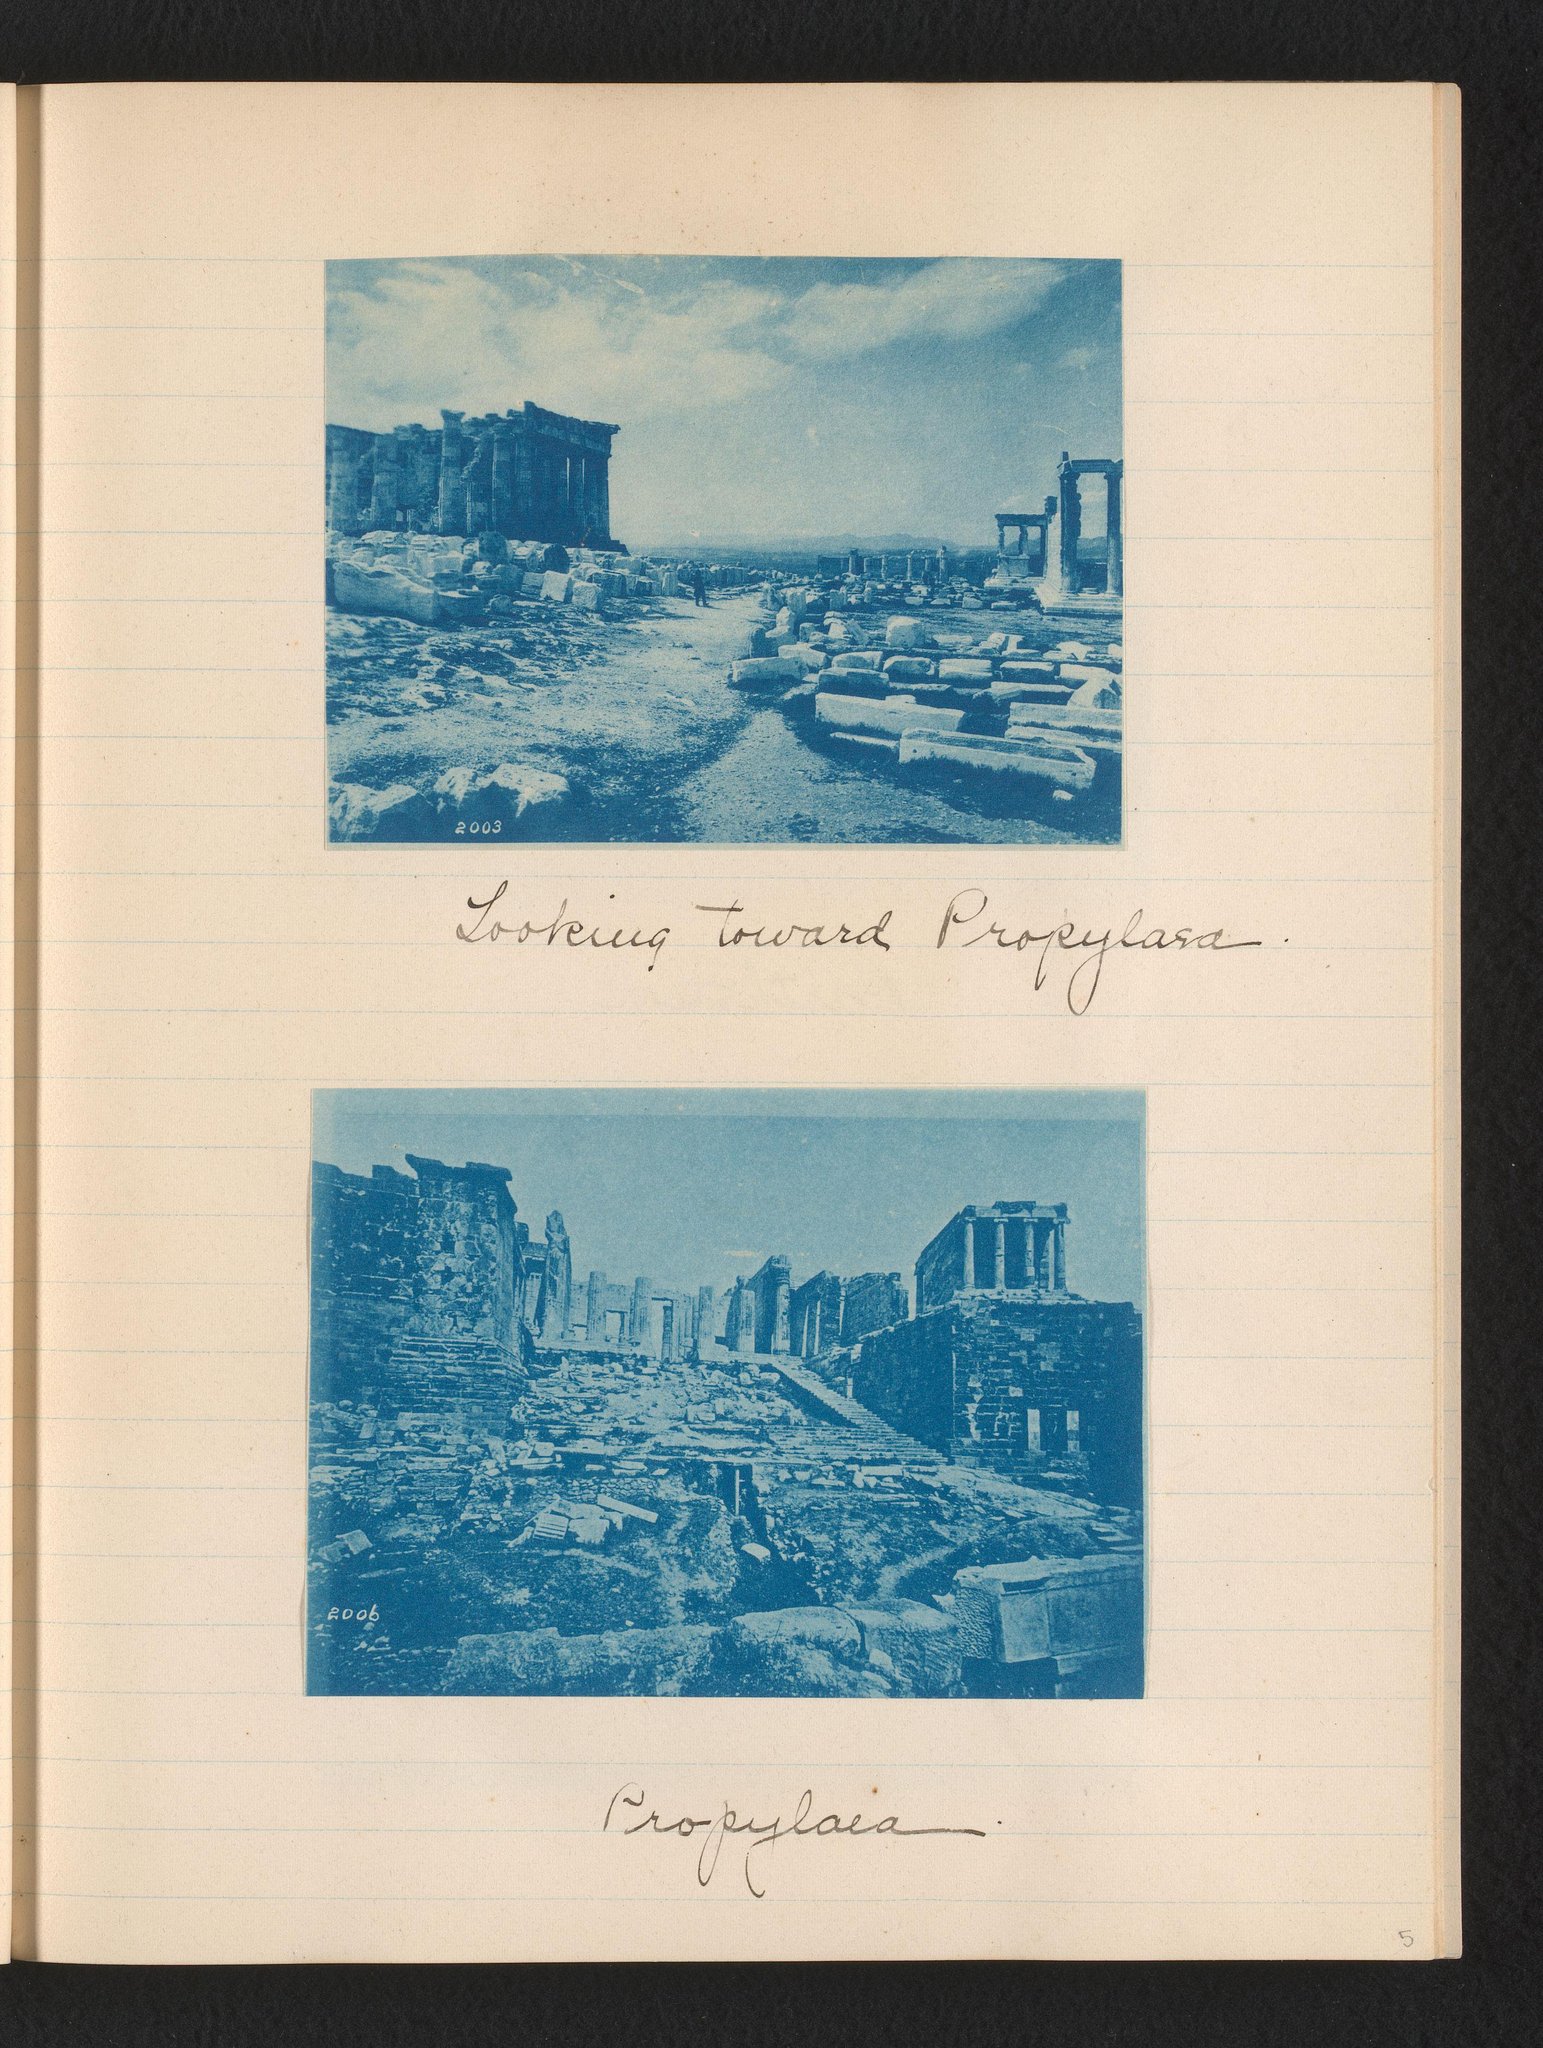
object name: album leaf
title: Twee foto's van de Akropolis van Athene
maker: Anonymous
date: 1901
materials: paper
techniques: cyanotype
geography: athens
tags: ruin of a building ~ architecture, temple, shrine ~ greek religion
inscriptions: inscription: ‘Looking toward Propylaea/ Propylaia’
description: Deze foto's maken deel uit van een album.